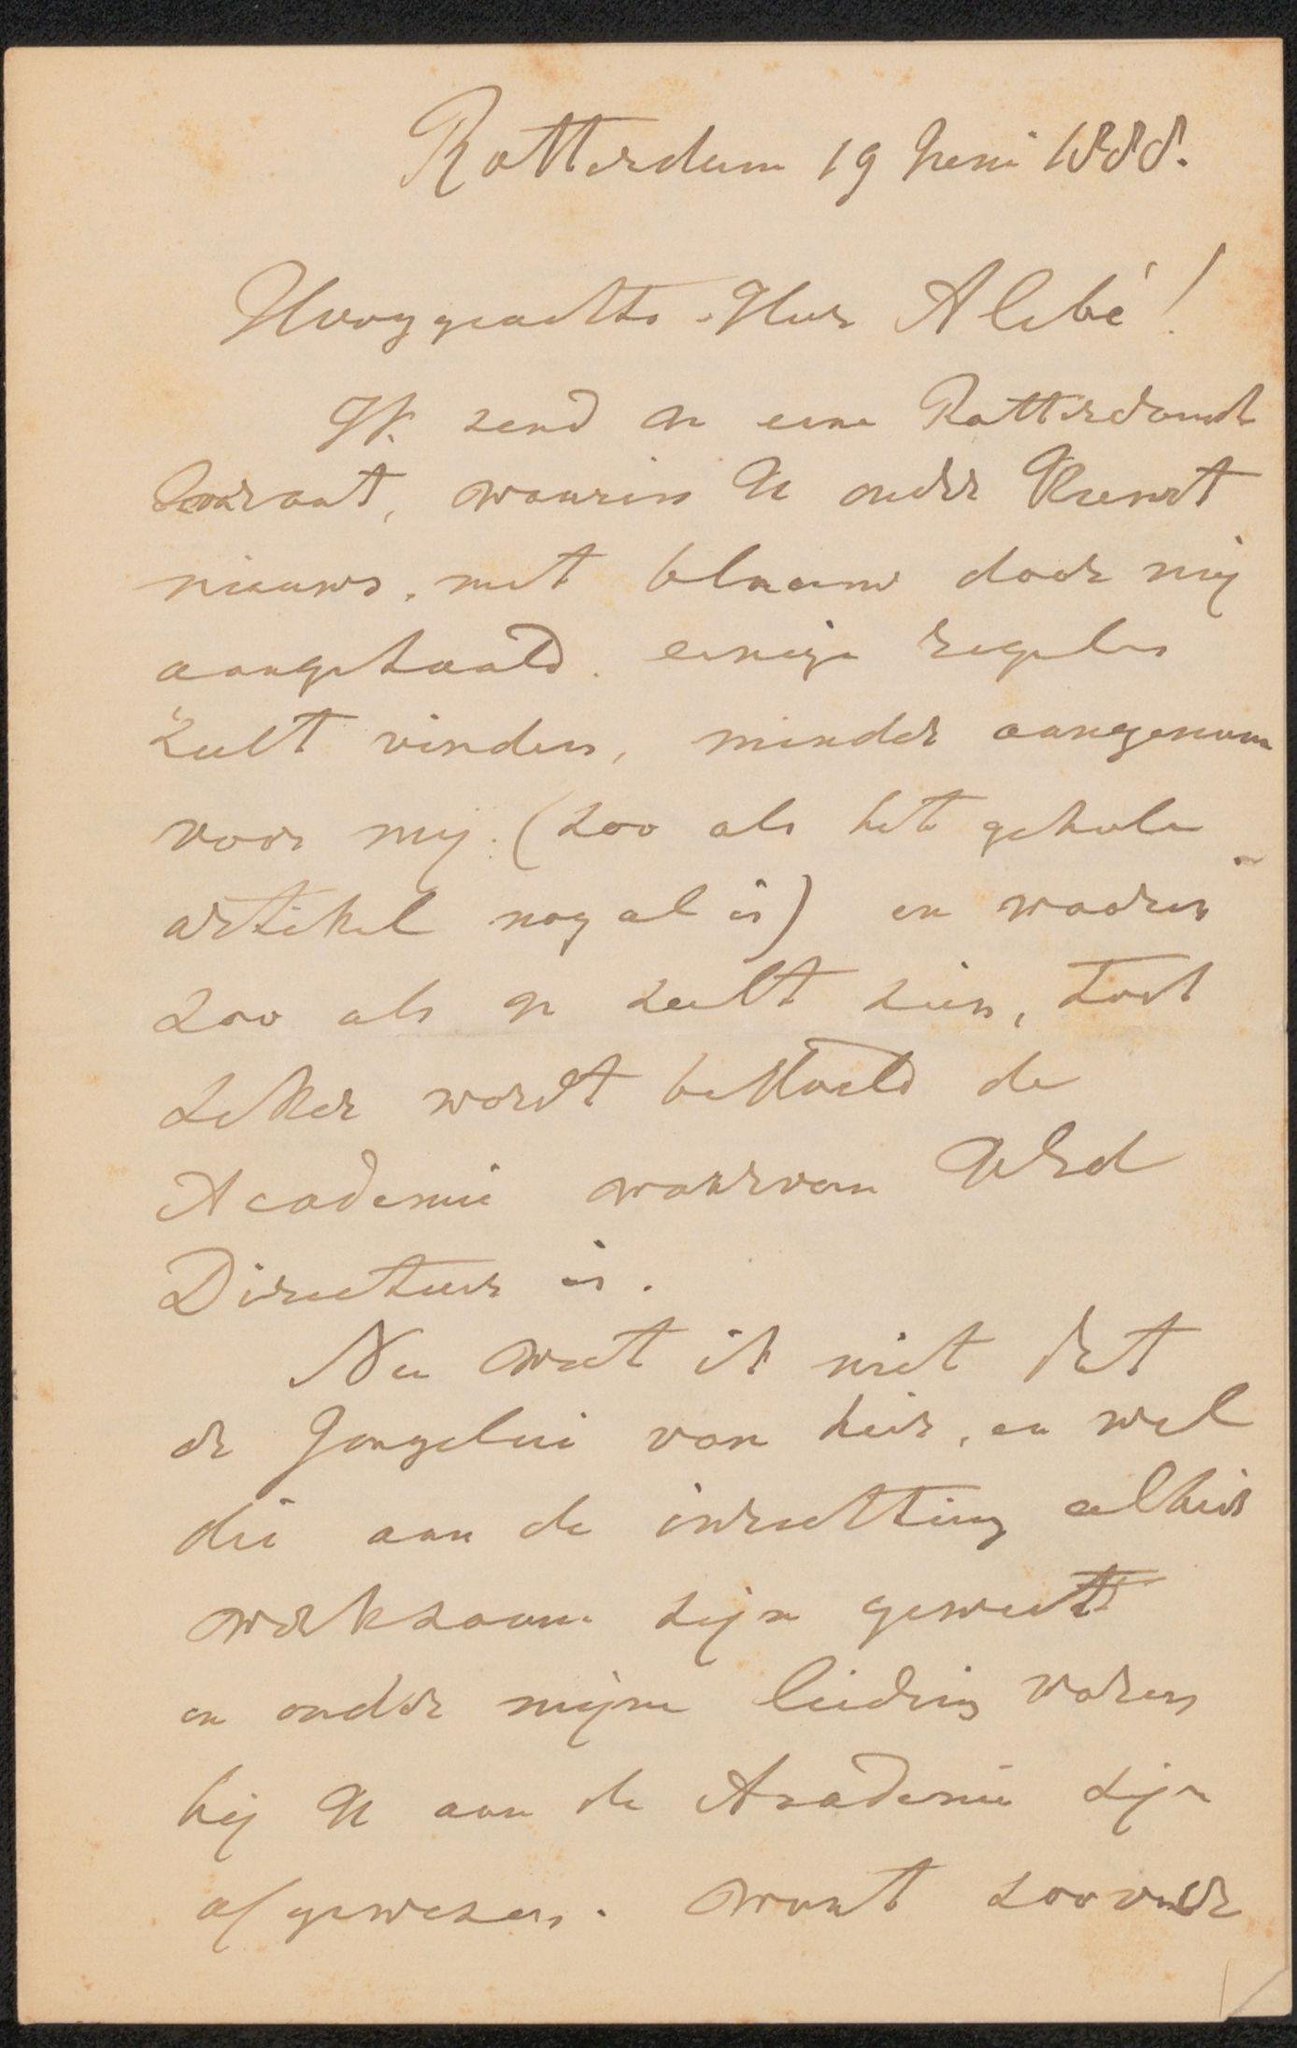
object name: letter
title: Brief aan August Allebé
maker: jan striening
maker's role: draughtsman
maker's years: 1827-1903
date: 1888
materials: ink, paper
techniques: pen, writing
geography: rotterdam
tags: amsterdam, august allebé, rotterdam, the hague, print maker, simon moulijn, pieter haverkorn van rijsewijk